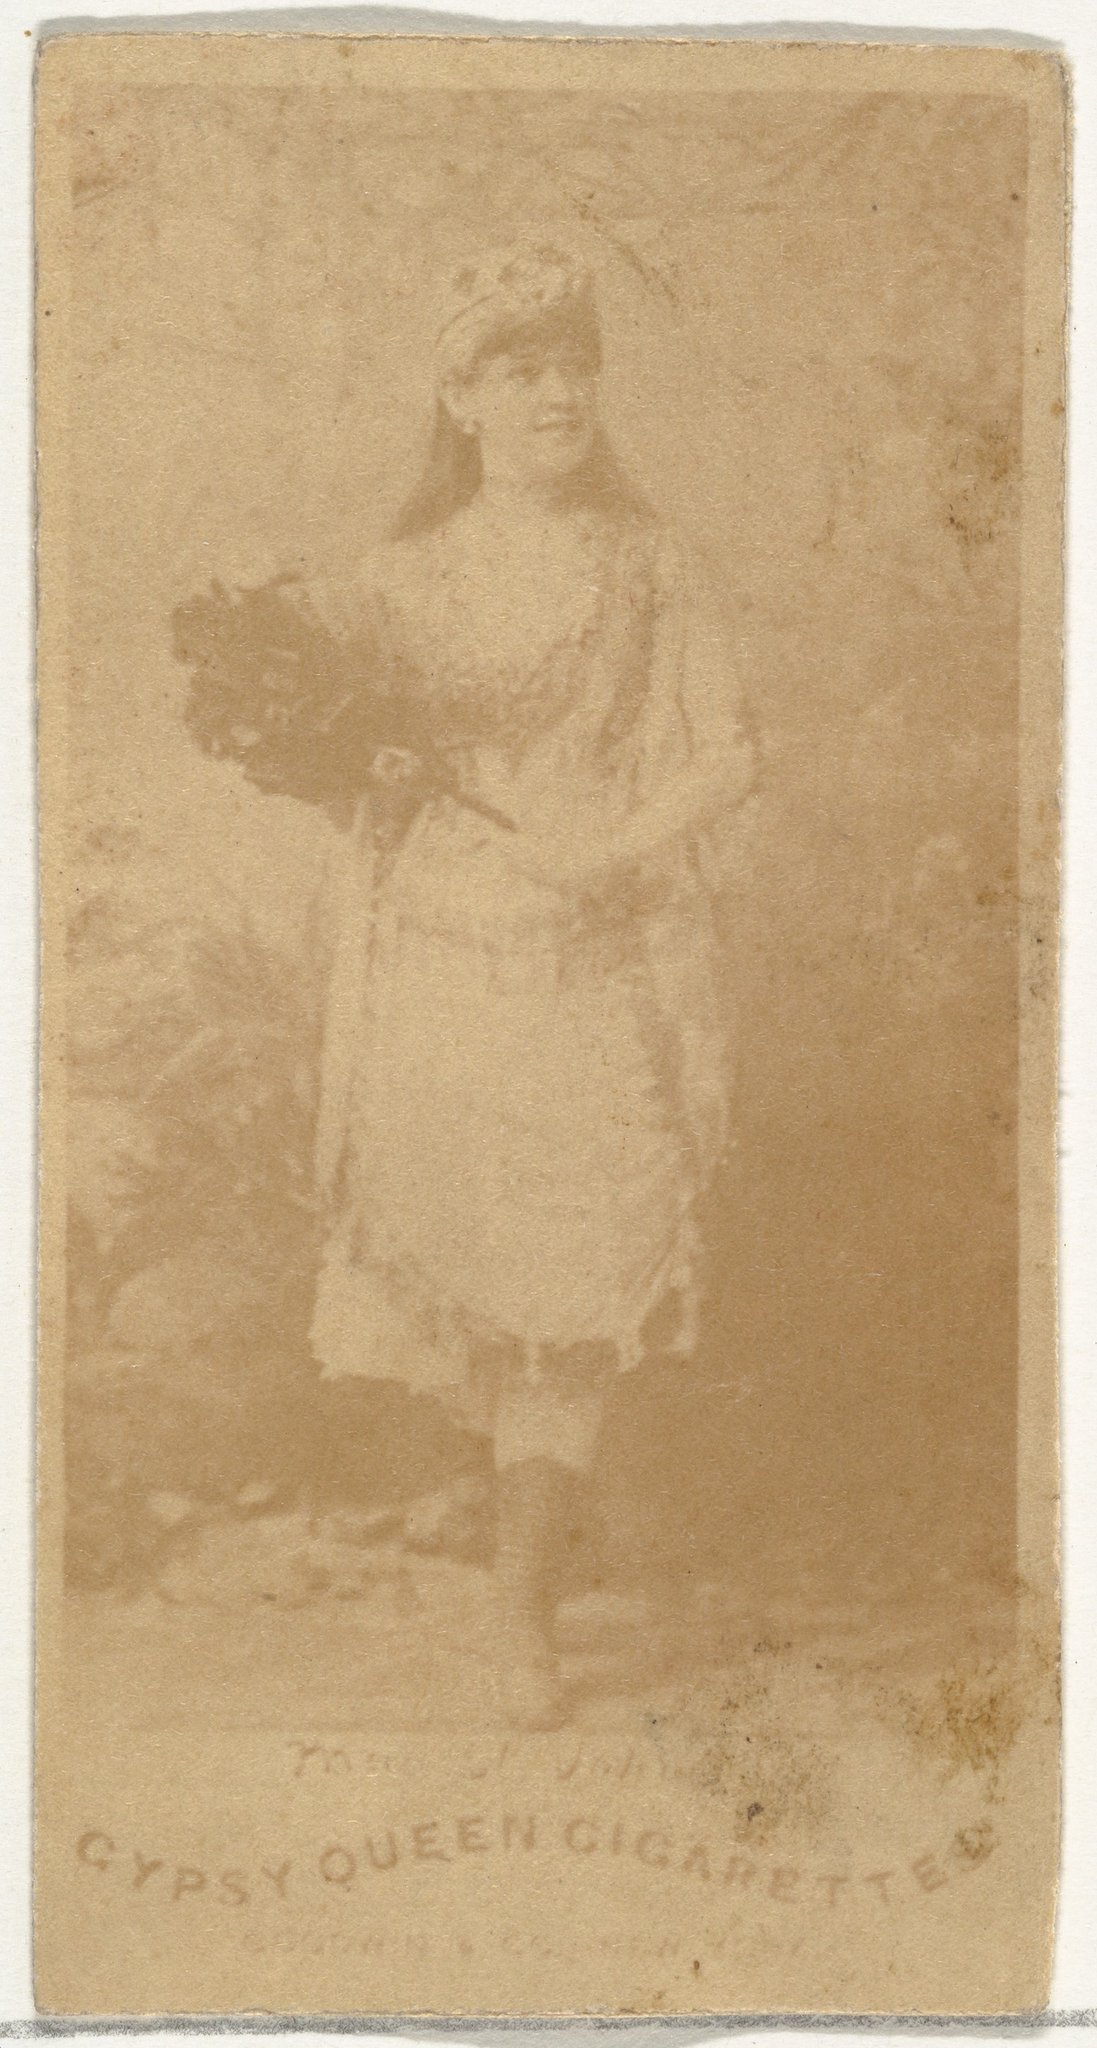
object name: photograph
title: From the Actors and Actresses series (N171) for Gypsy Queen Cigarettes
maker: goodwin & company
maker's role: publisher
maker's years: 1850-1950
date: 1886-1890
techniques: albumen silver print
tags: portraits,women,actresses